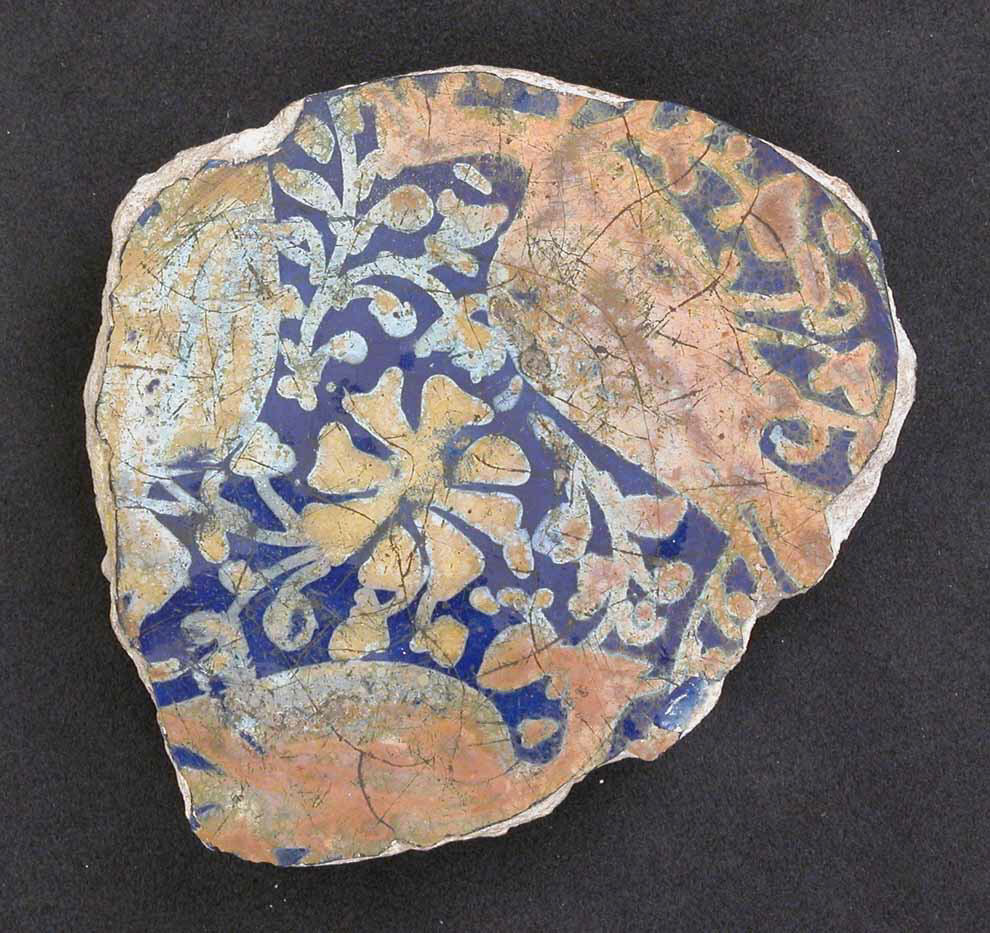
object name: fragment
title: Ceramic Fragment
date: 1301-1400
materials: stonepaste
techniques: painting, underglaze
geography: egypt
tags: flowers